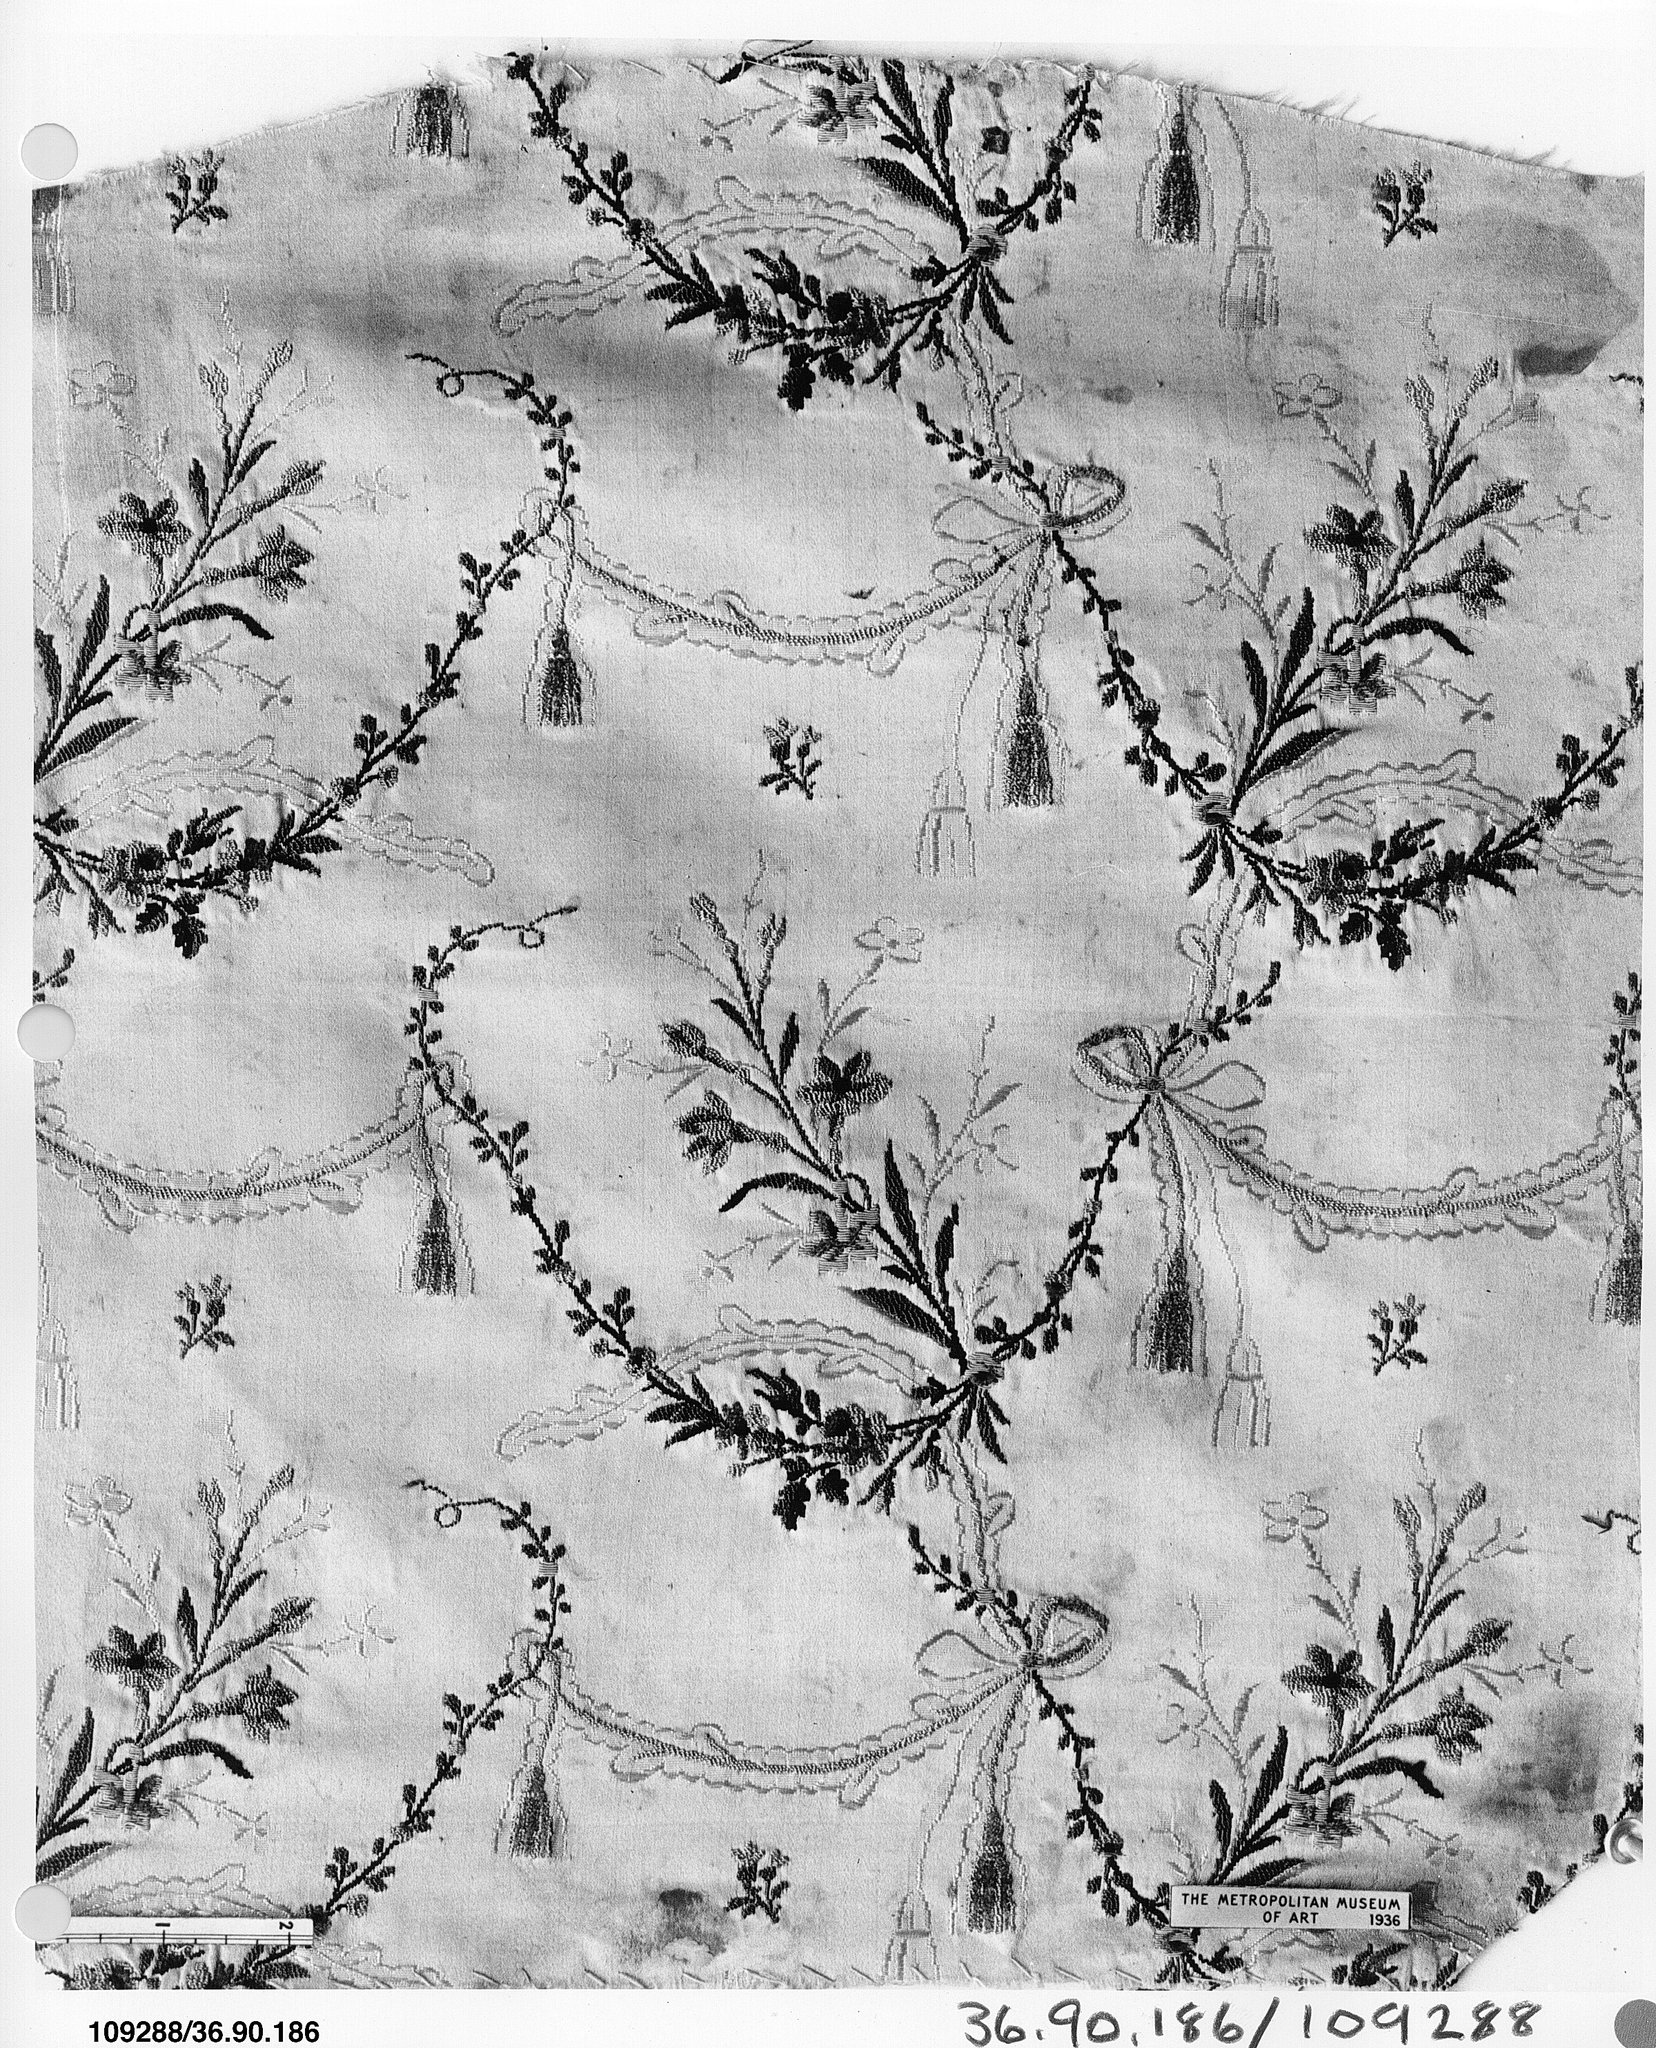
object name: piece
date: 1701-1800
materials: silk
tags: flowers,leaves